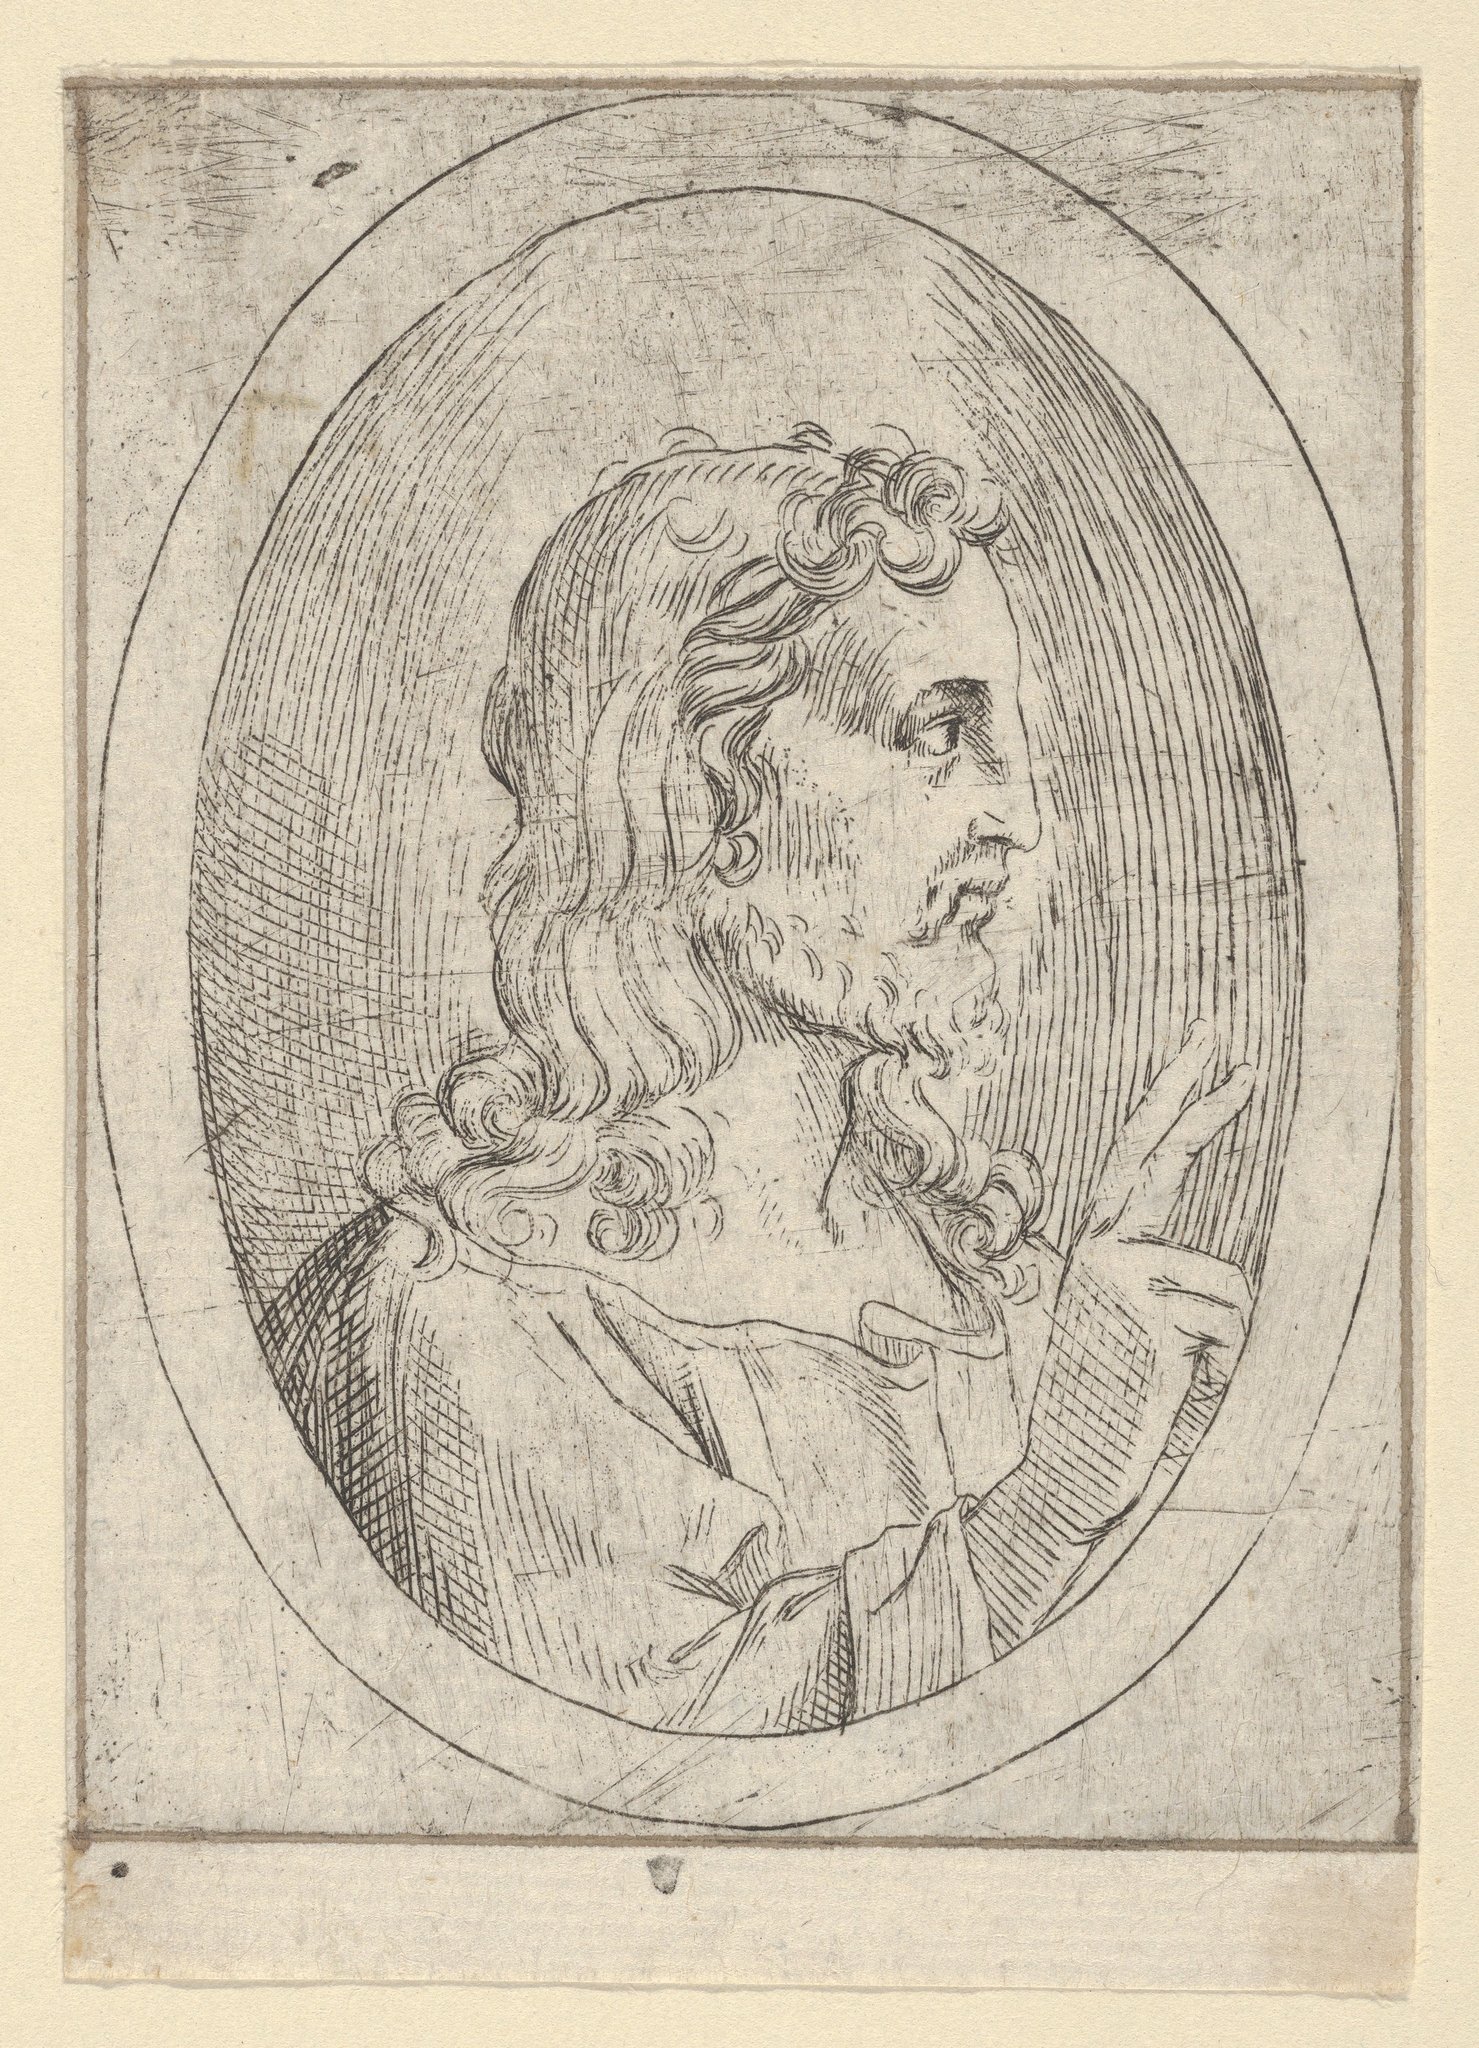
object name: print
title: Christ seen in profile facing right, making the sign of blessing with his right hand, in an oval frame, from "Christ, the Virgin, and Thirteen Apostles"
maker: anonymous, 17th century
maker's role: artist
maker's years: 1600-1700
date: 1600-1640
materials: ink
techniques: etching, pen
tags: profiles,christ